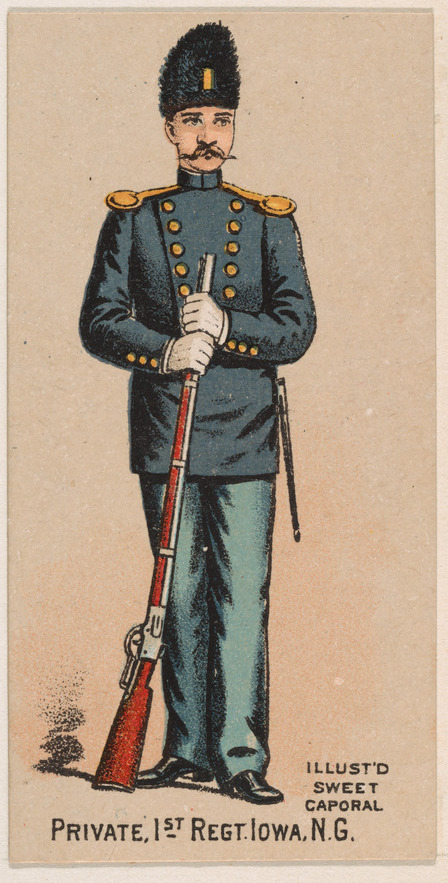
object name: print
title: Private, 1st Regiment, Iowa, National Guard, from the Military Series (N224) issued by Kinney Tobacco Company to promote Sweet Caporal Cigarettes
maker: kinney brothers tobacco company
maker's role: publisher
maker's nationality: american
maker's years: 1869-2011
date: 1888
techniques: color lithograph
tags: military,firearms,men